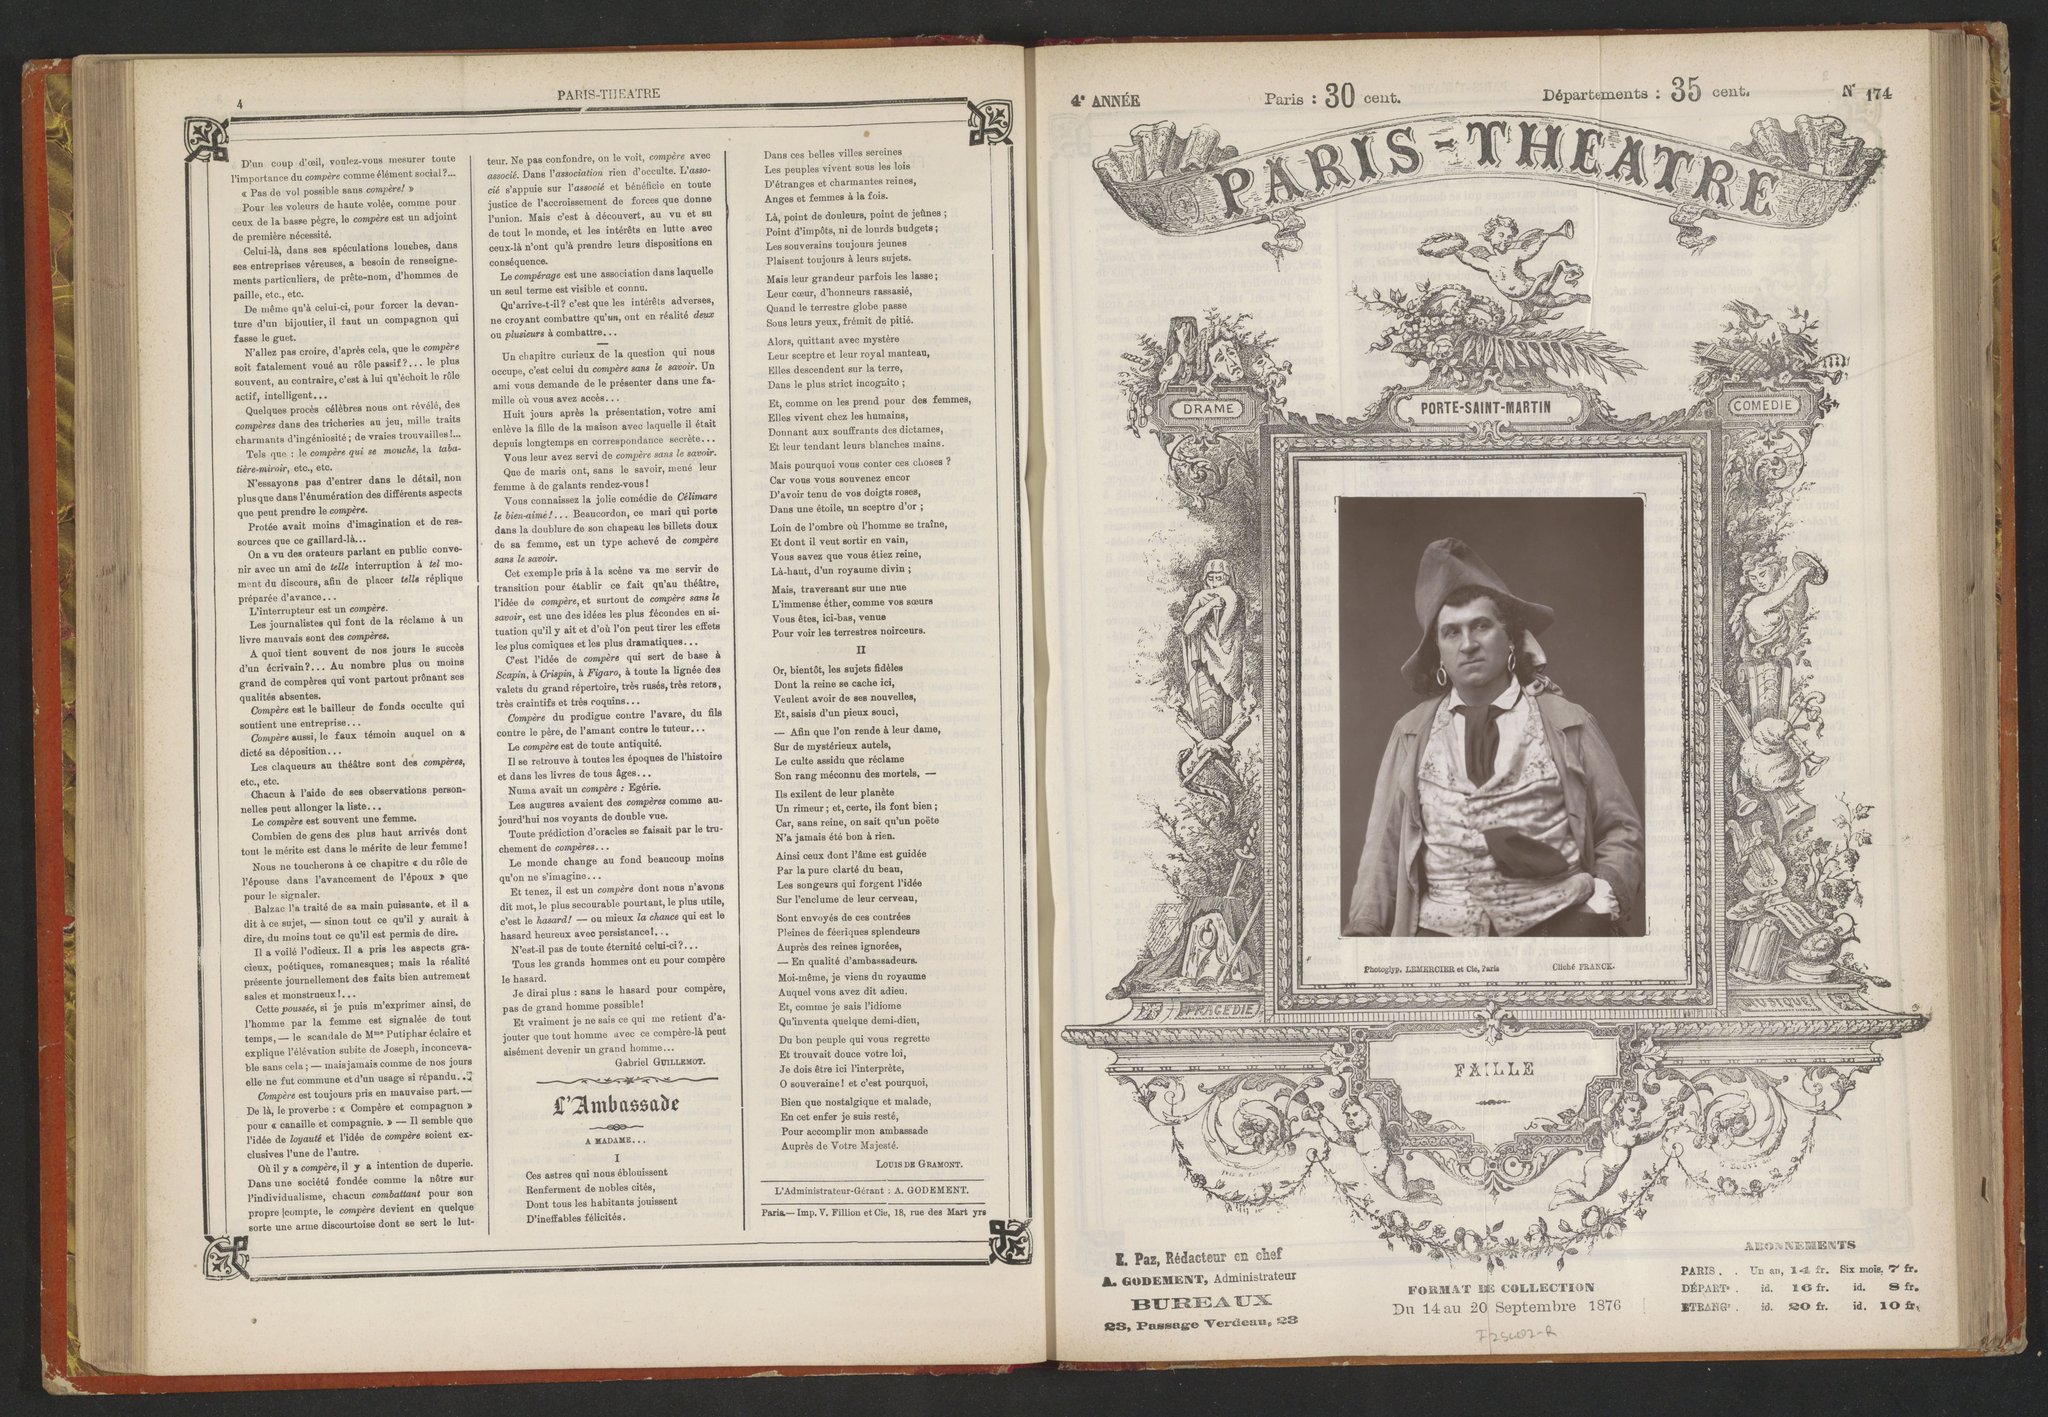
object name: photomechanical print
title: Faille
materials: paper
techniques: woodburytype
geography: paris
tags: portrait of actor, actress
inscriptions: number: ‘No 174’, inscription: ‘Du 14 au 20 Septembre 1876’